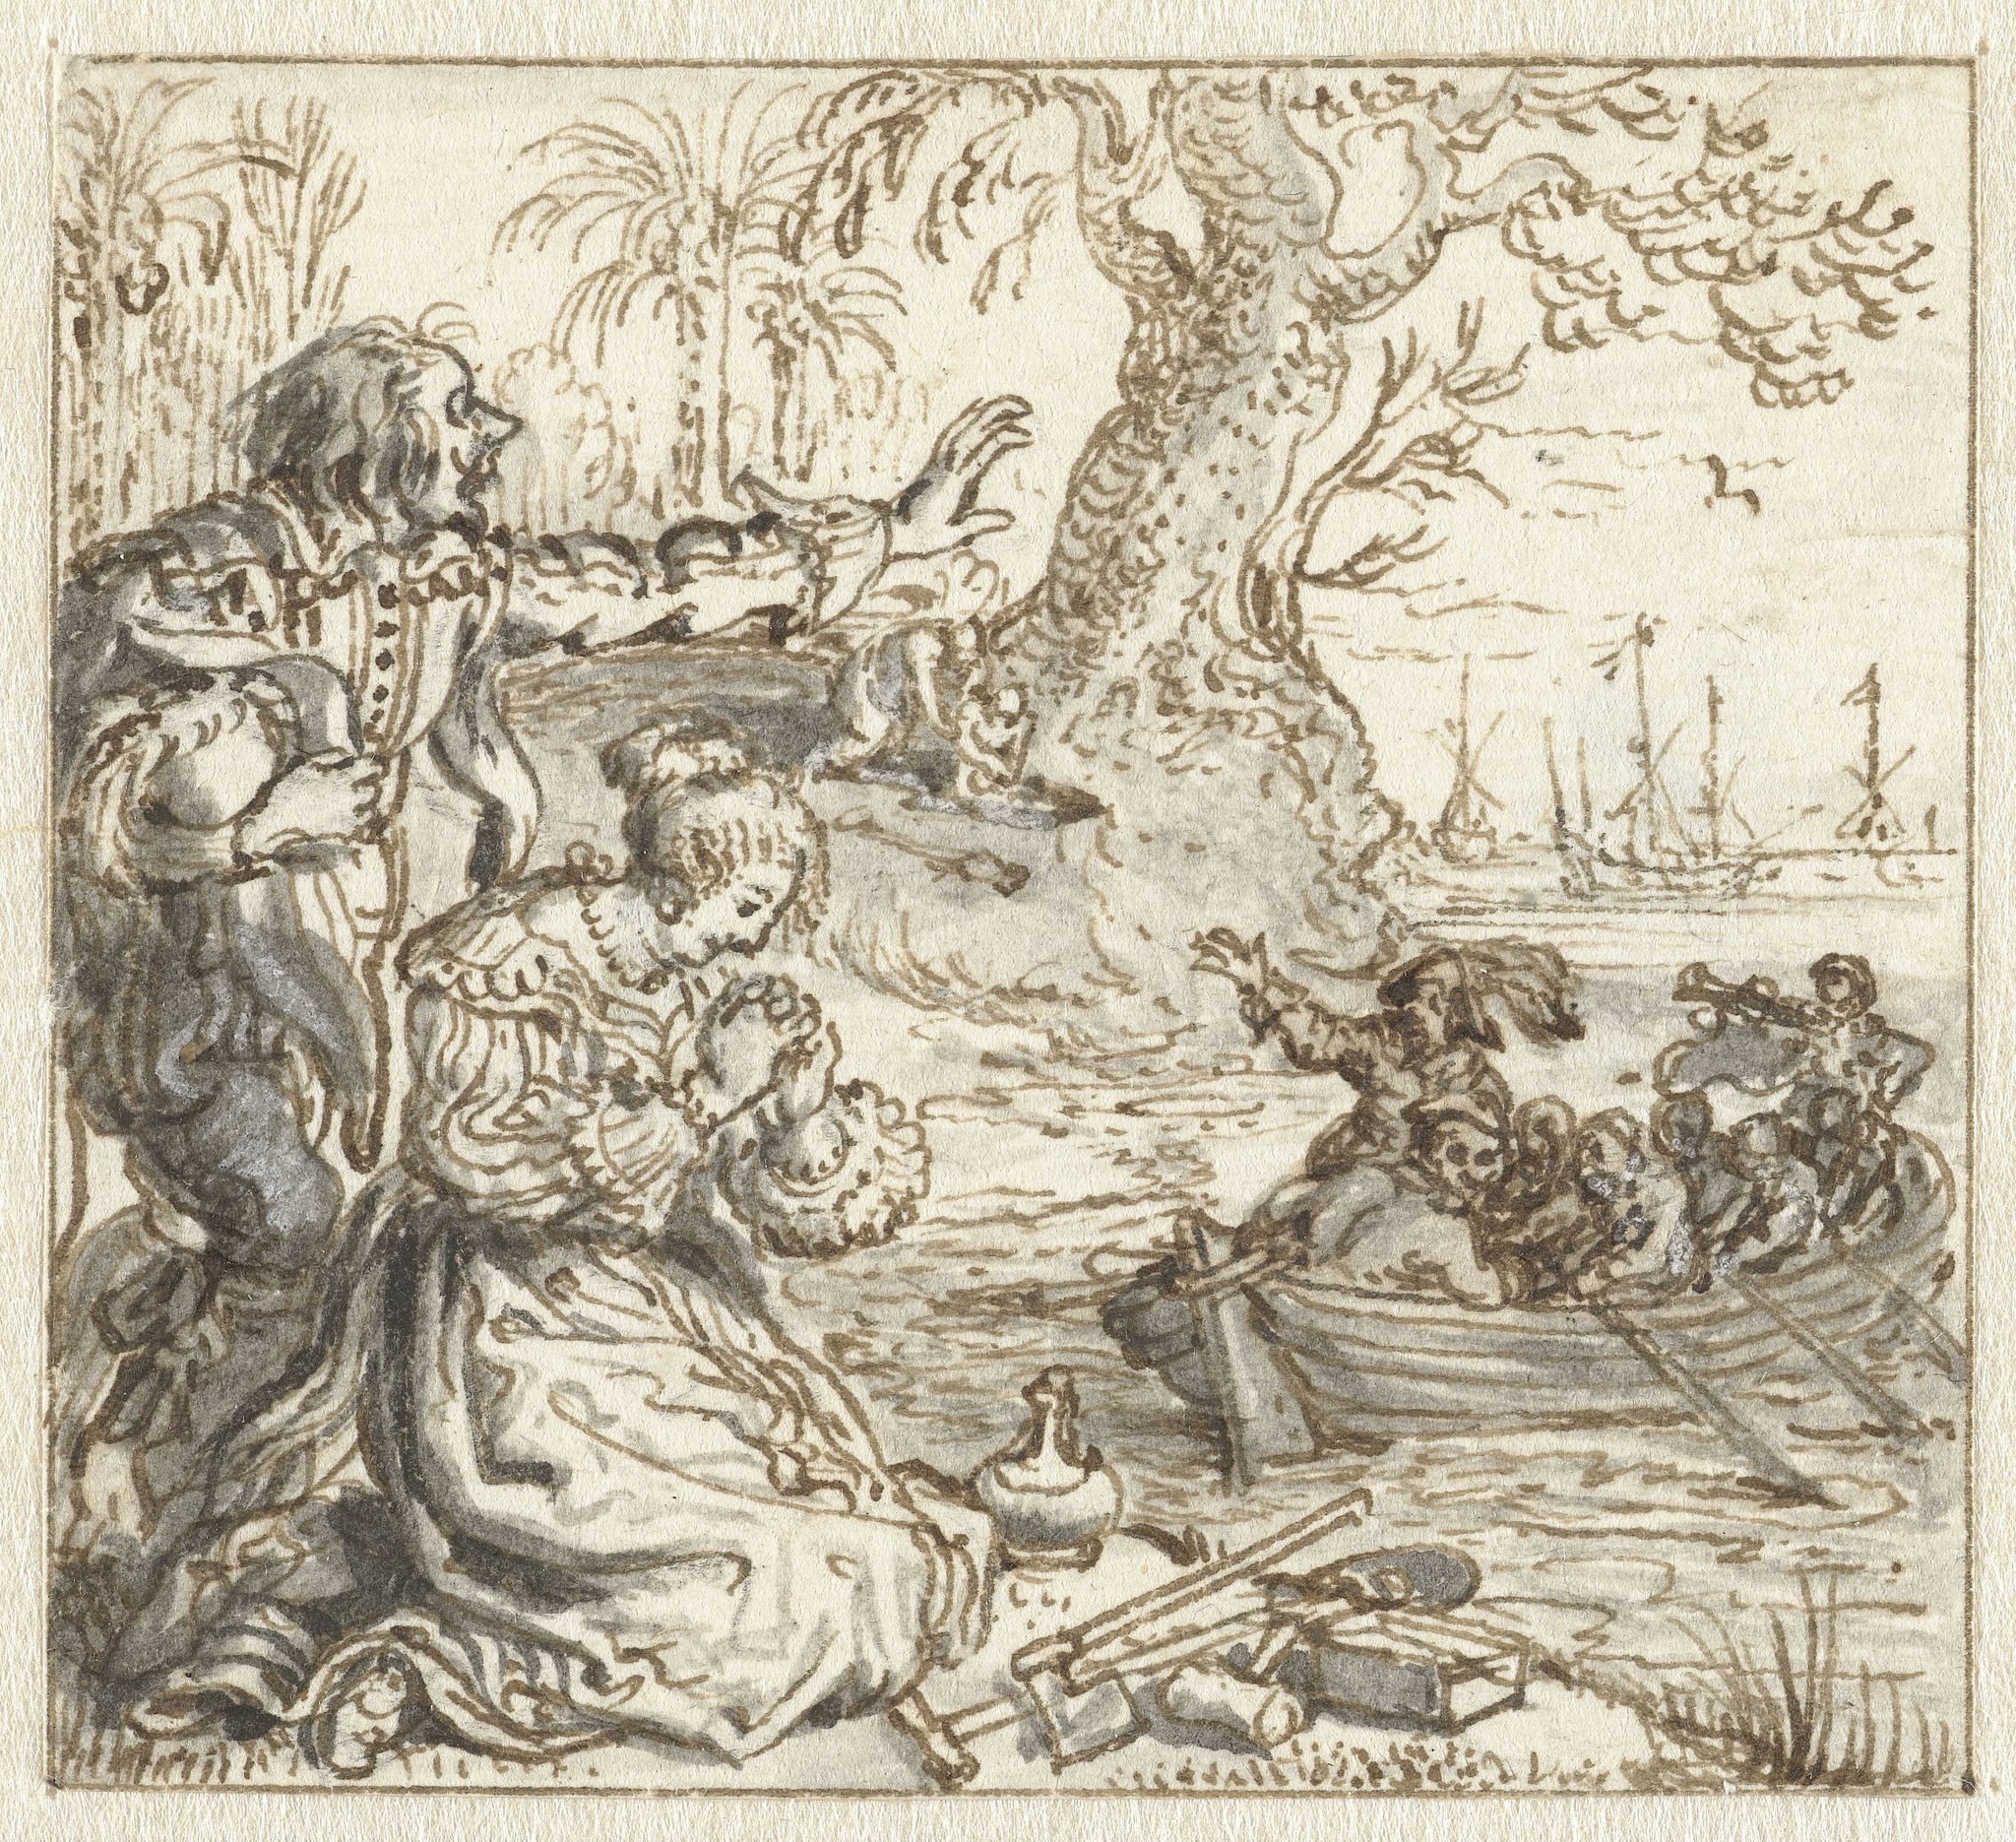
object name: drawing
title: Galant and Pregnant Rosette Abandoned on a Desert Island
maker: adriaen pietersz van de venne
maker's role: draughtsman, painter, print maker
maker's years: 1589-1662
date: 1634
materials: paint, ink, paper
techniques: brush, pen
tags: (scenes from) specific works of literature (with author, title), female literary characters (with name), male literary characters (with name)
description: Ontwerp voor een illustratie in Jacob Cats' 'Hovwelyck ...' van 1634: Rosette en Galant zien de schepelingen het onbewoonde eiland verlaten.